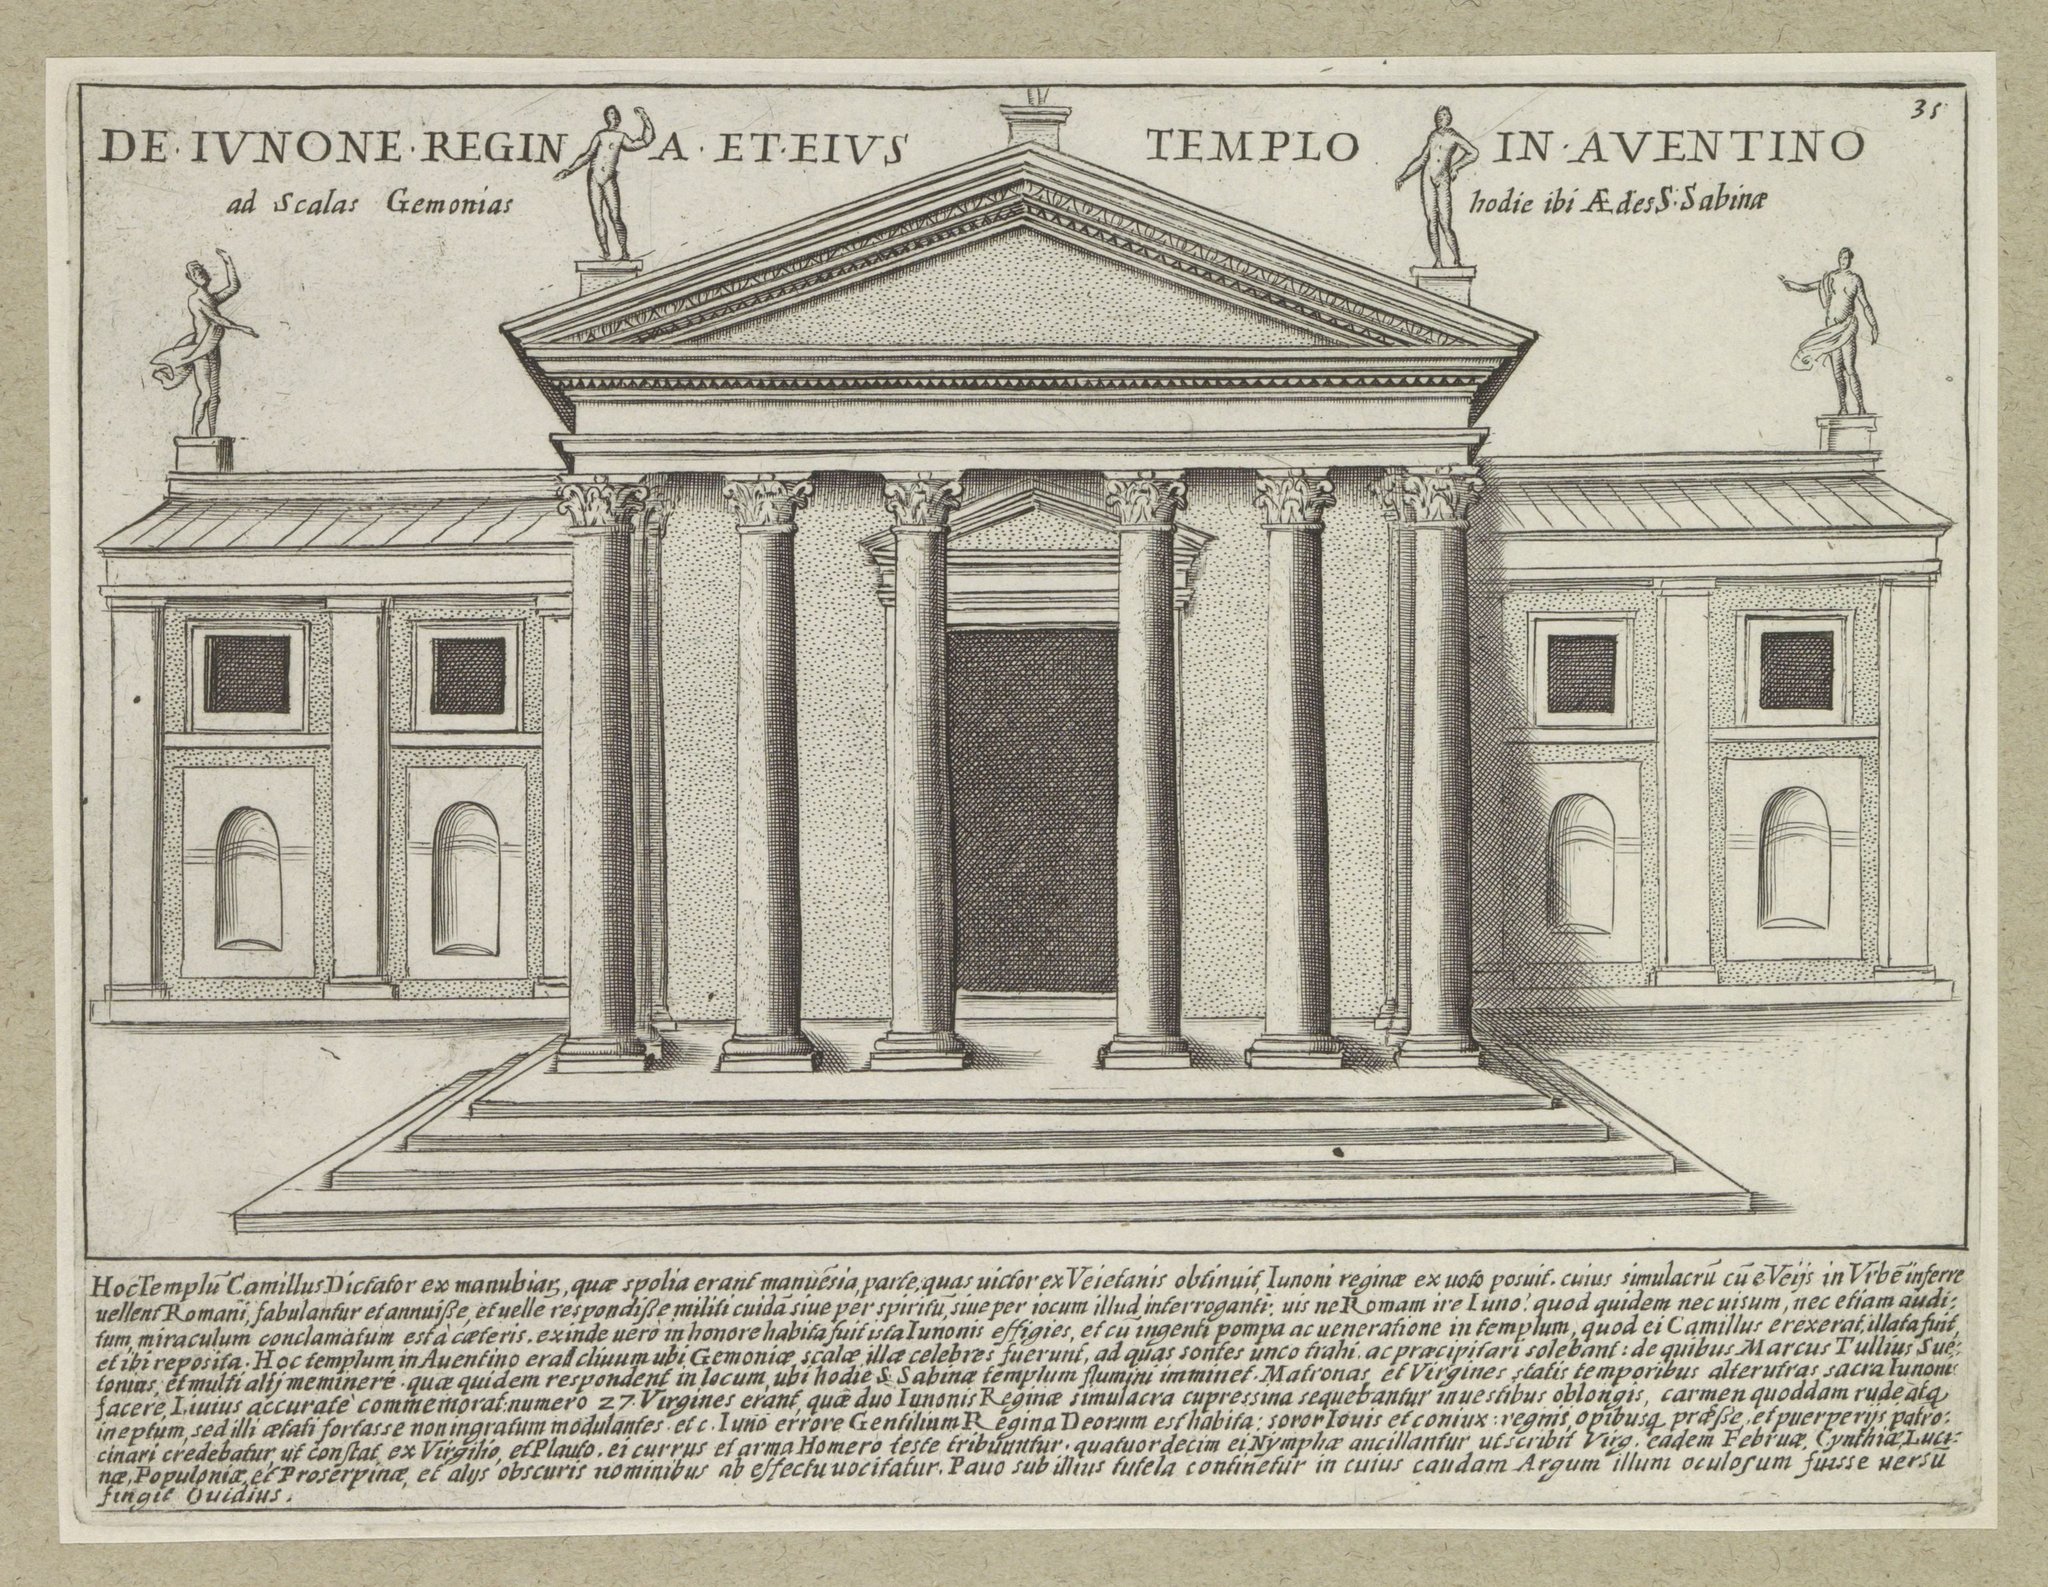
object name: album leaf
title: Tempel van Juno Regina op de Aventijn te Rome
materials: paper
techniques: etching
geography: rome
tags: temple, shrine ~ roman religion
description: Deze prent maakt deel uit van een set van 158 prenten (+ titelprenten), die verscheen in vier delen. In 1612 verschenen delen één en twee. In 1615 verscheen het derde deel en in 1628 verscheen deel vier. In 1637 publiceerde Vitale Mascardi de eerste heruitgave van de gehele set met nummering.